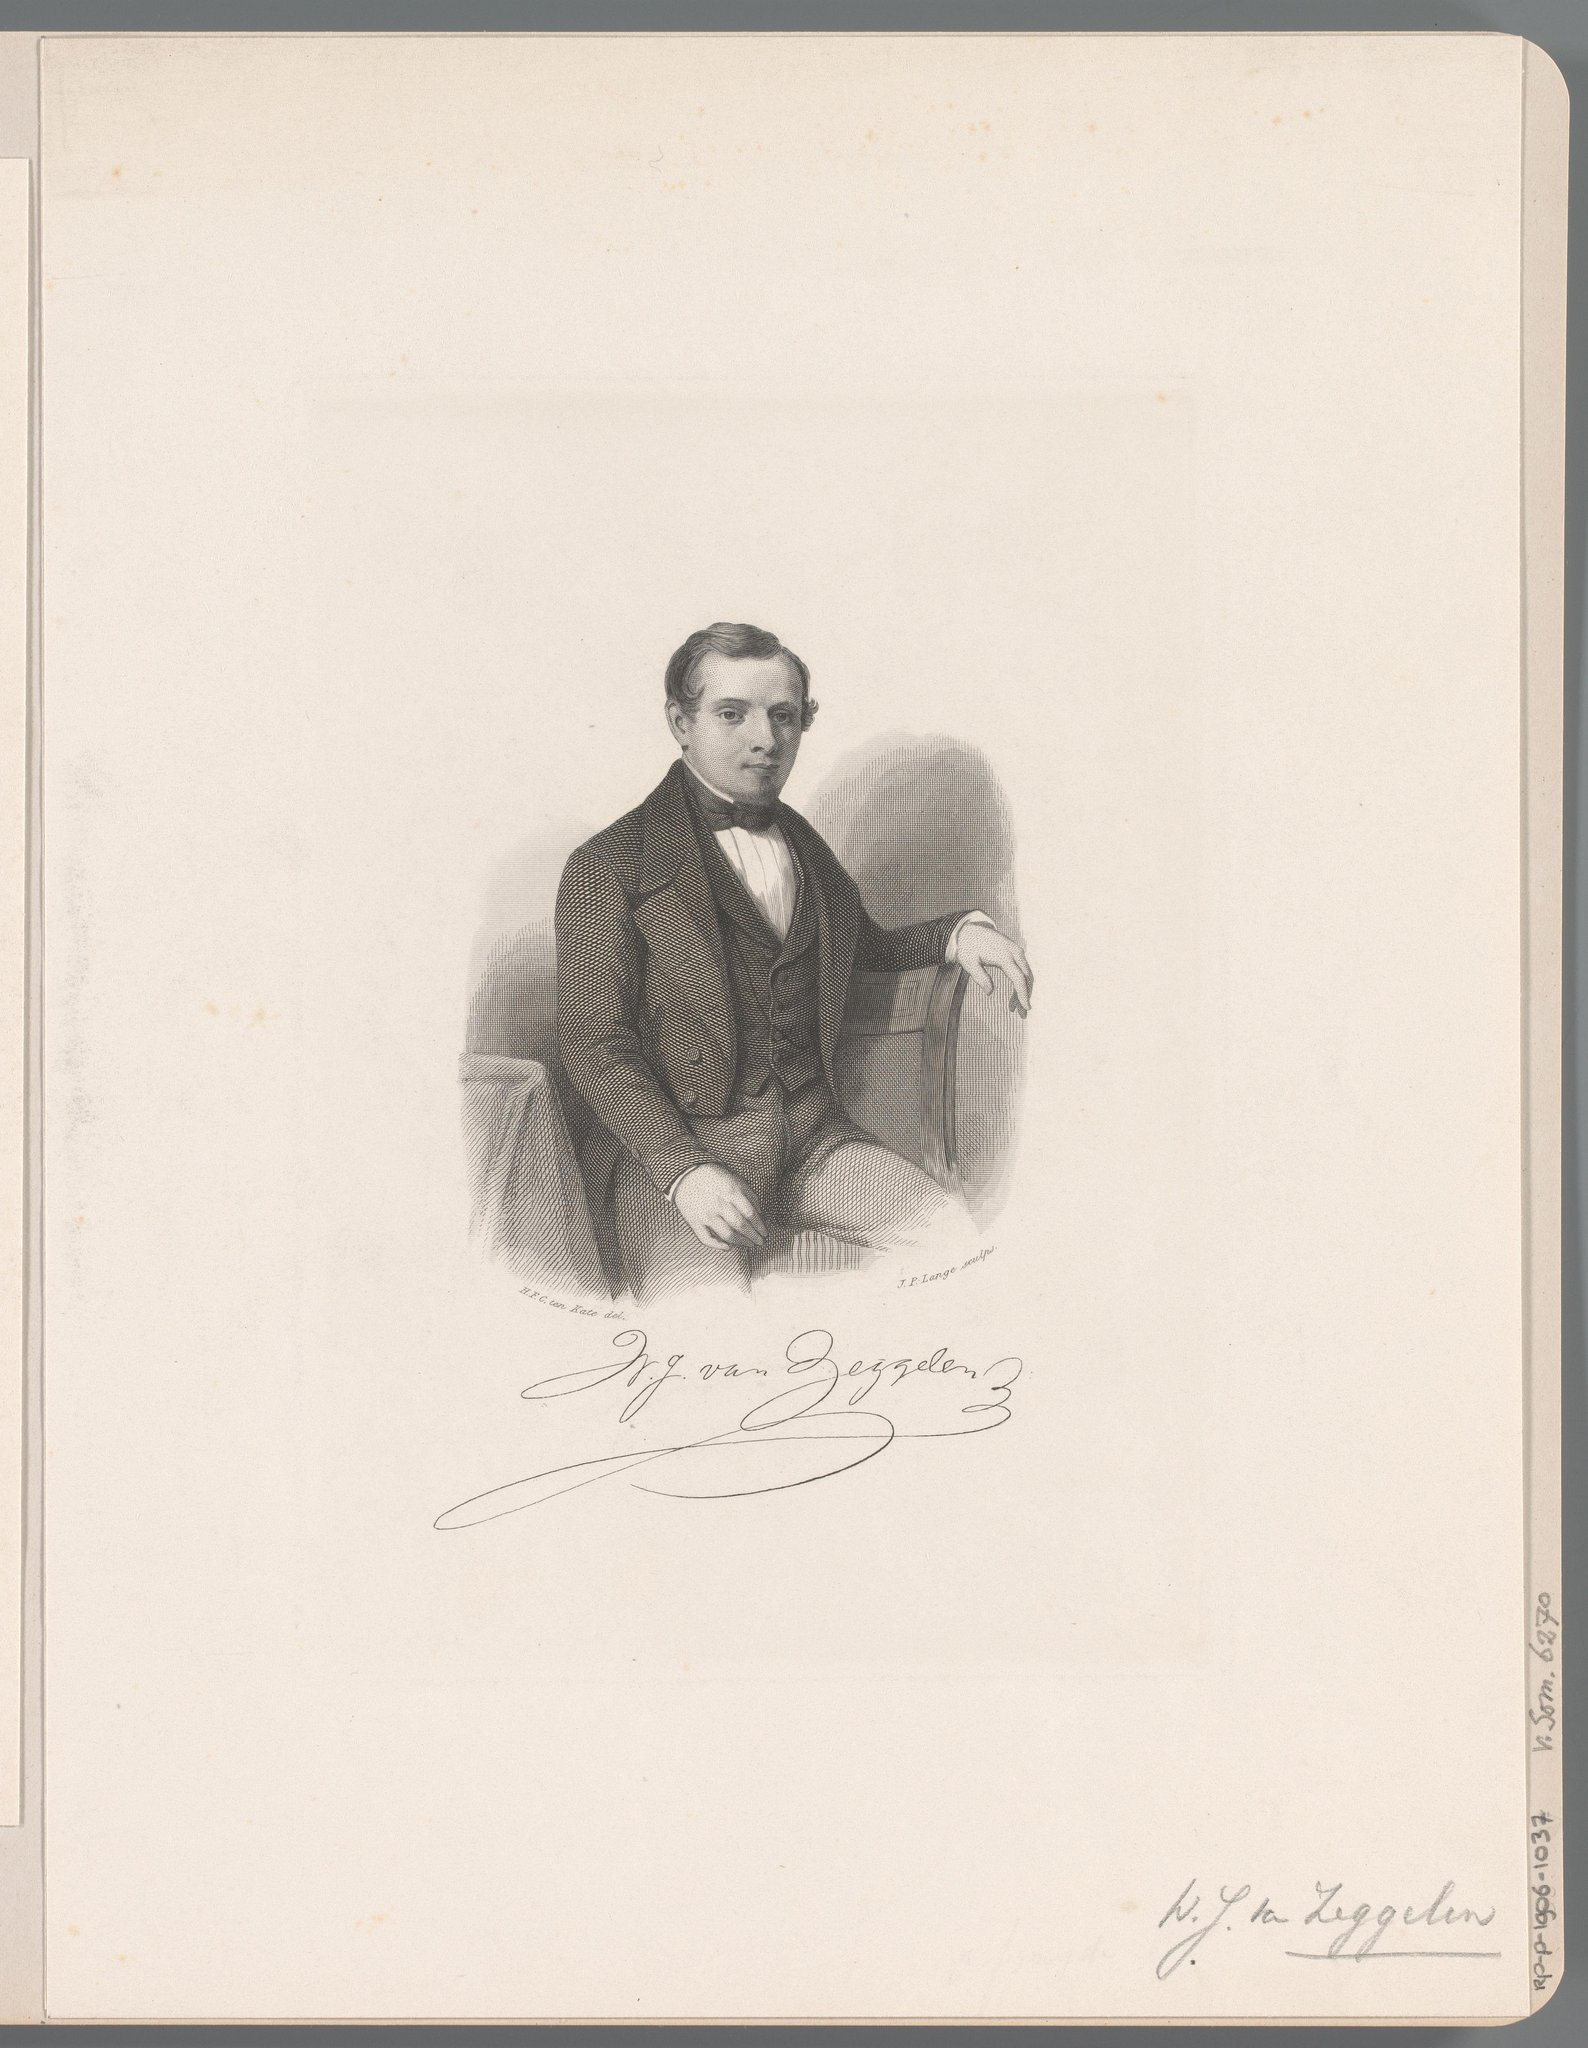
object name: print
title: Portret van Willem Josephus van Zeggelen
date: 1847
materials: paper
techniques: engraving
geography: amsterdam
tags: the hague, historical persons, writer, poet, author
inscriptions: collector's mark: Lugt 2228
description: Prent waarschijnlijk uit: Nederlandsche Muzen-Almanak 29 (1847).